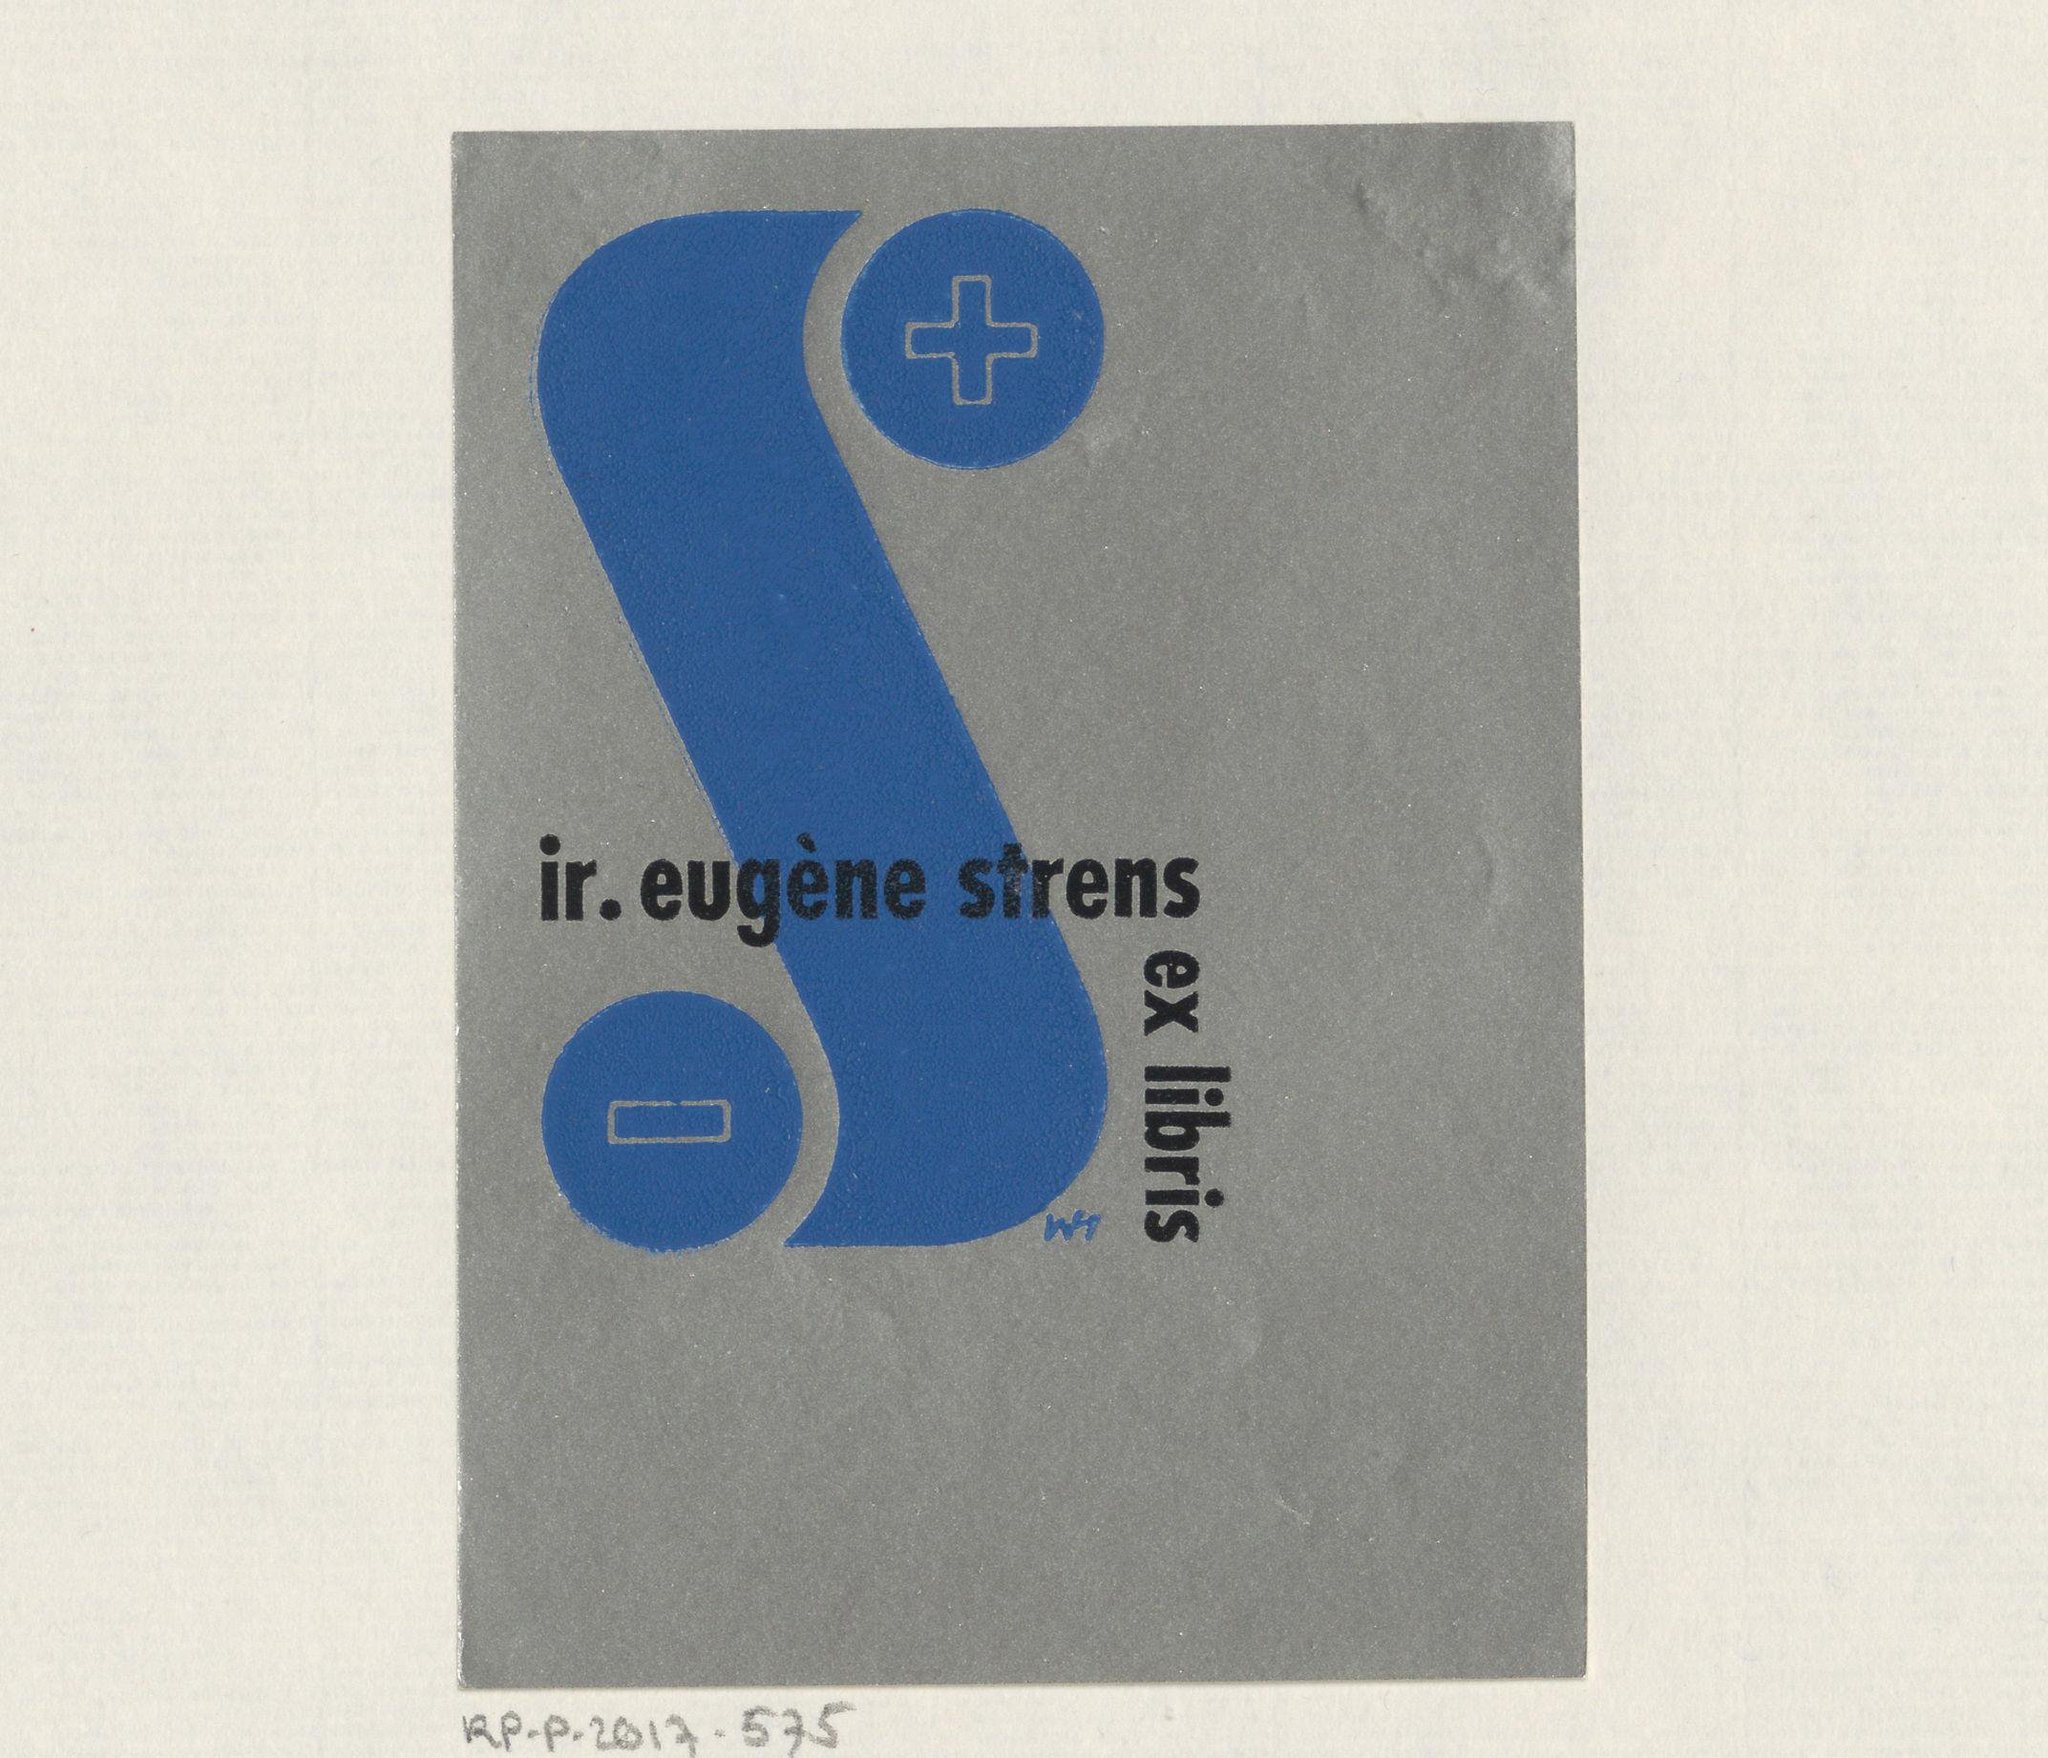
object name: bookplate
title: Ex libris van Eugène Strens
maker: Anonymous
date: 1900-1980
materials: paper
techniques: printing block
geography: netherlands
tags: engineer, eugène louis charles marie strens